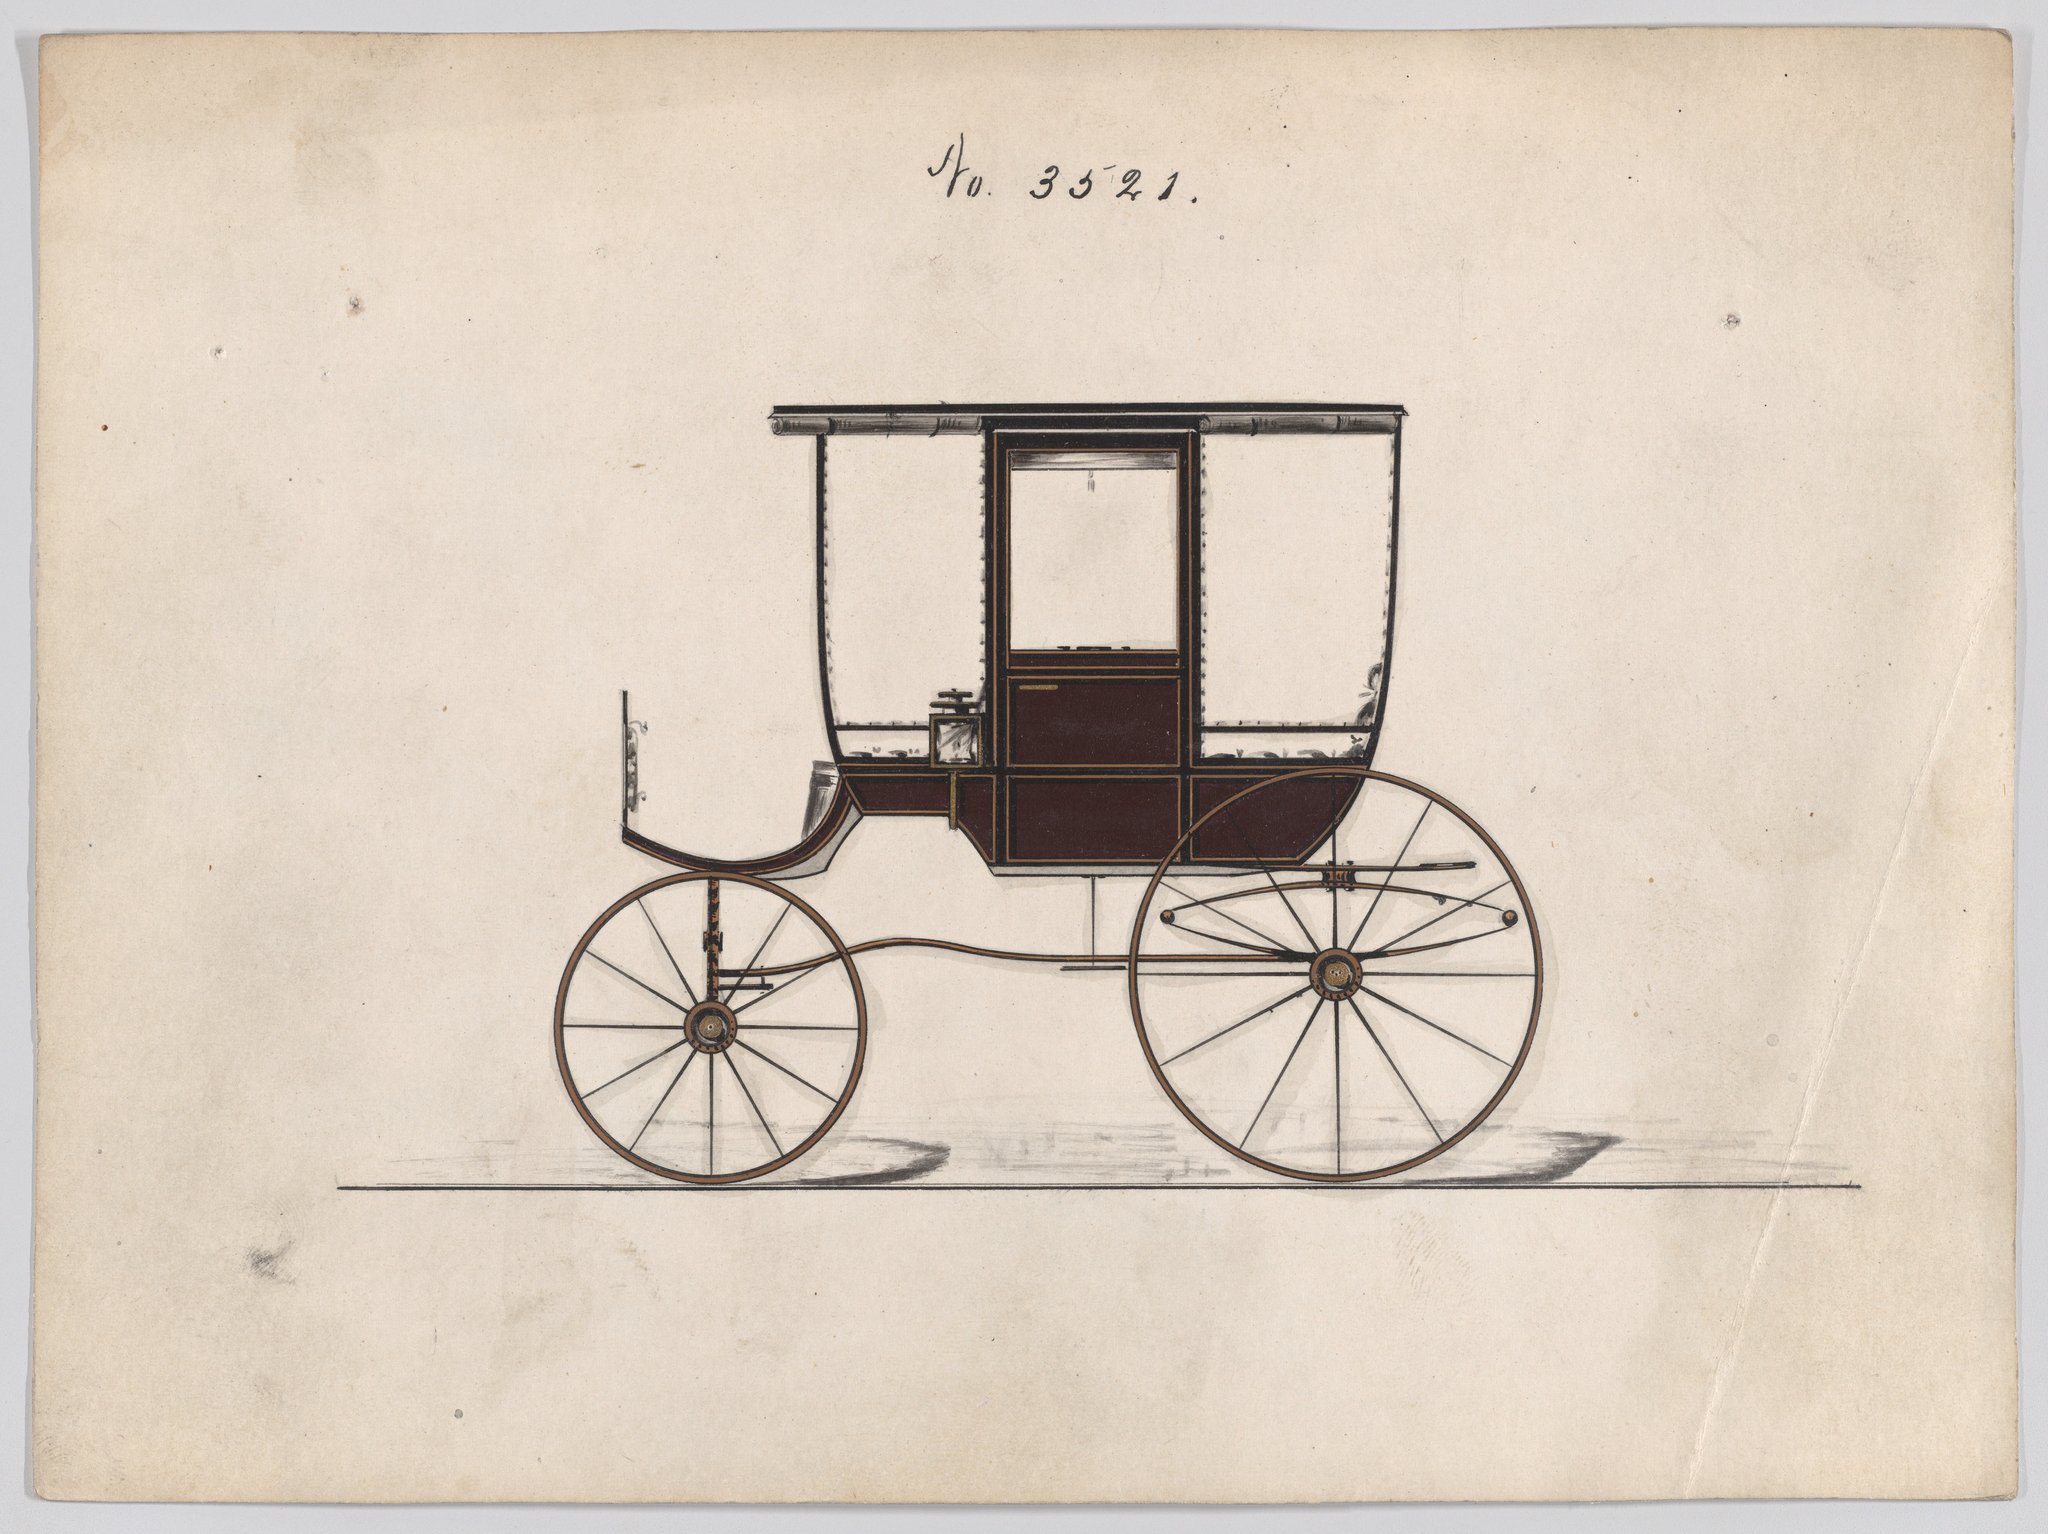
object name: drawing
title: Design for 6 seat Rockaway, no. 3521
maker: brewster & co.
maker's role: manufacturer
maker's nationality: american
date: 1879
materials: gouache, gum arabic, ink, watercolor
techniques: pen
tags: carriages